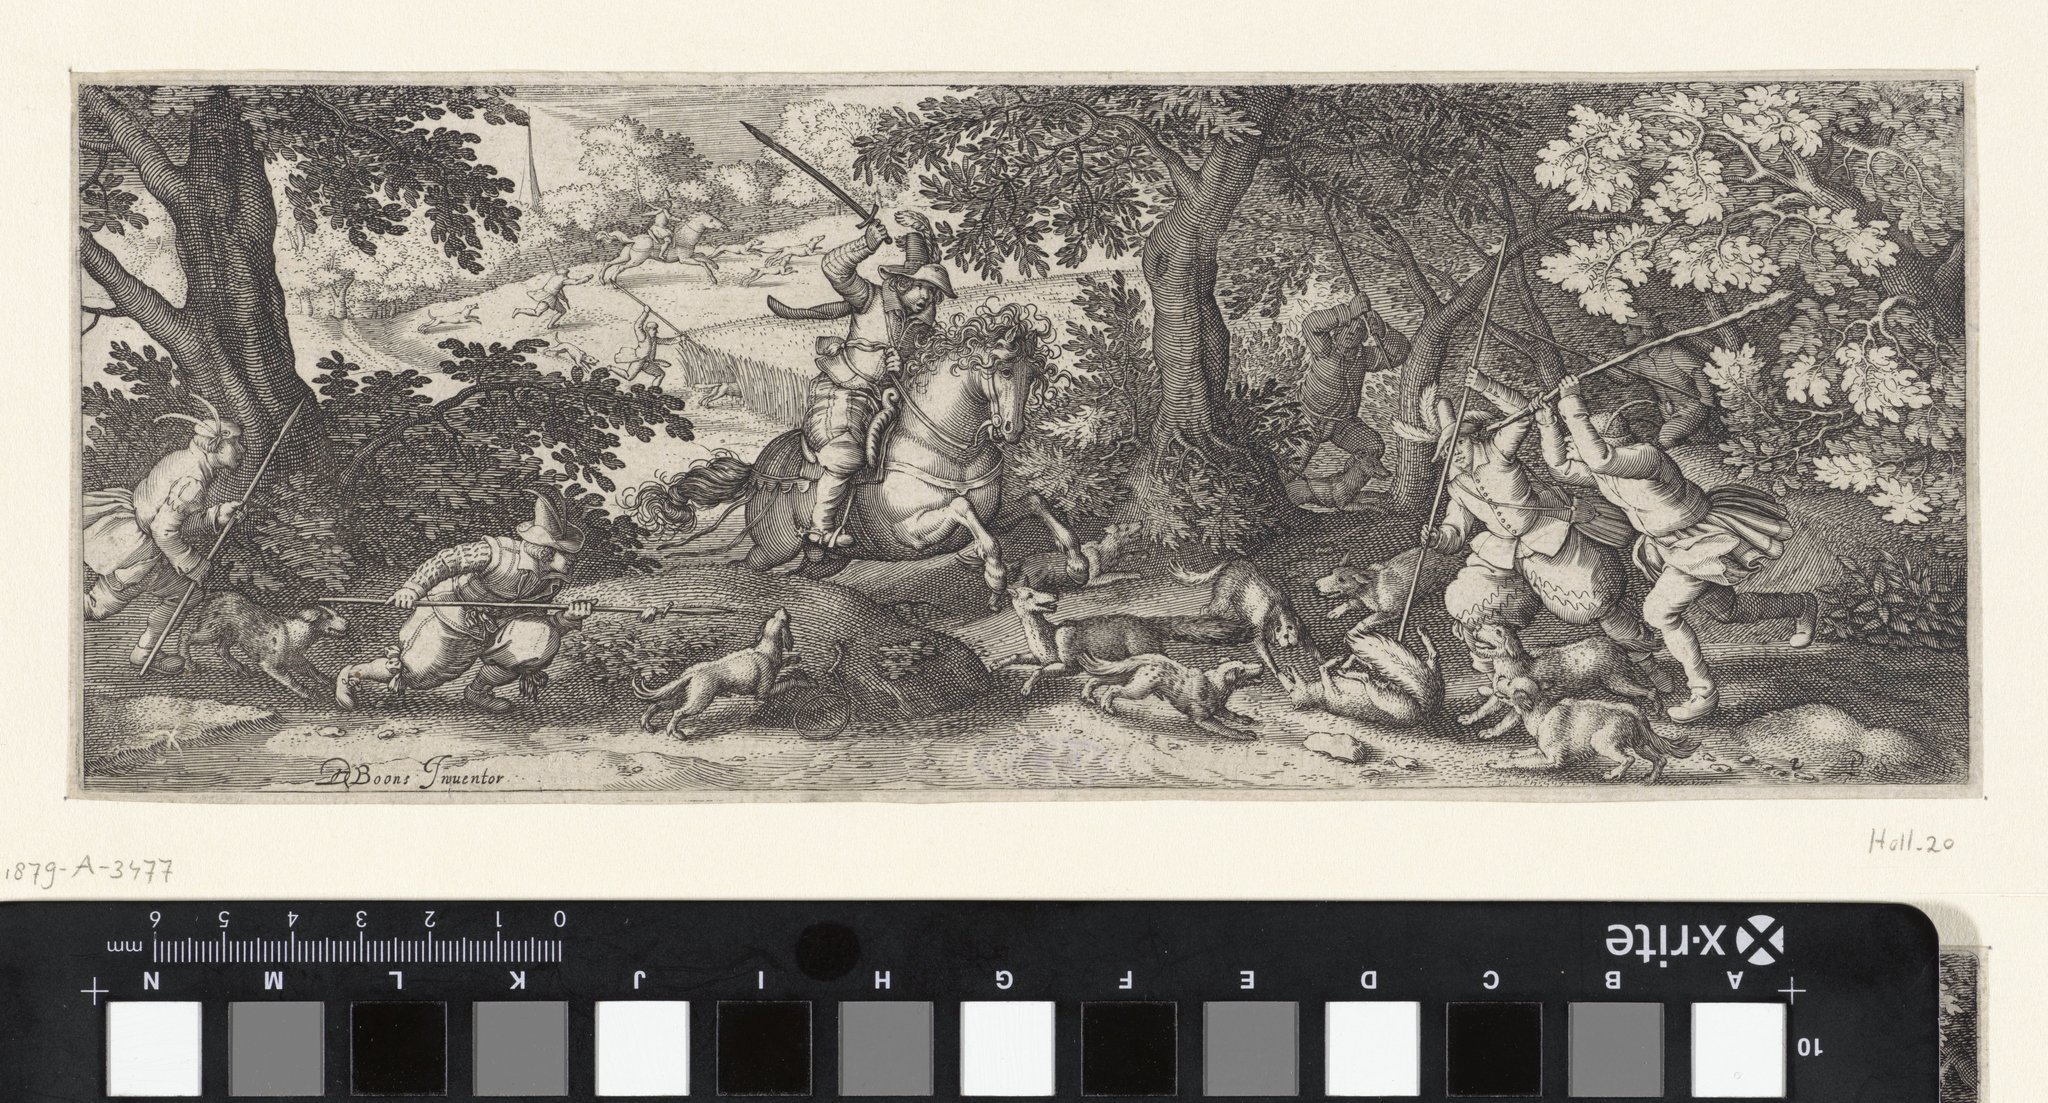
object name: print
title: Fox Hunt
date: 1612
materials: paper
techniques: engraving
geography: amsterdam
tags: hunting, chase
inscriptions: collector's mark: Lugt 2228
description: Een man te paard nadert met opgeheven zwaard een op zijn rug liggende vos, die door honden in het nauw is gedreven. Vier andere mannen rennen naar het dier toe met speren en knuppels: een van hen spietst de vos. Daarachter zit een vos vast door een strik om zijn lijf. Een man met een stok in de aanslag rent er naar toe. Op de achtergrond een drijfjacht.